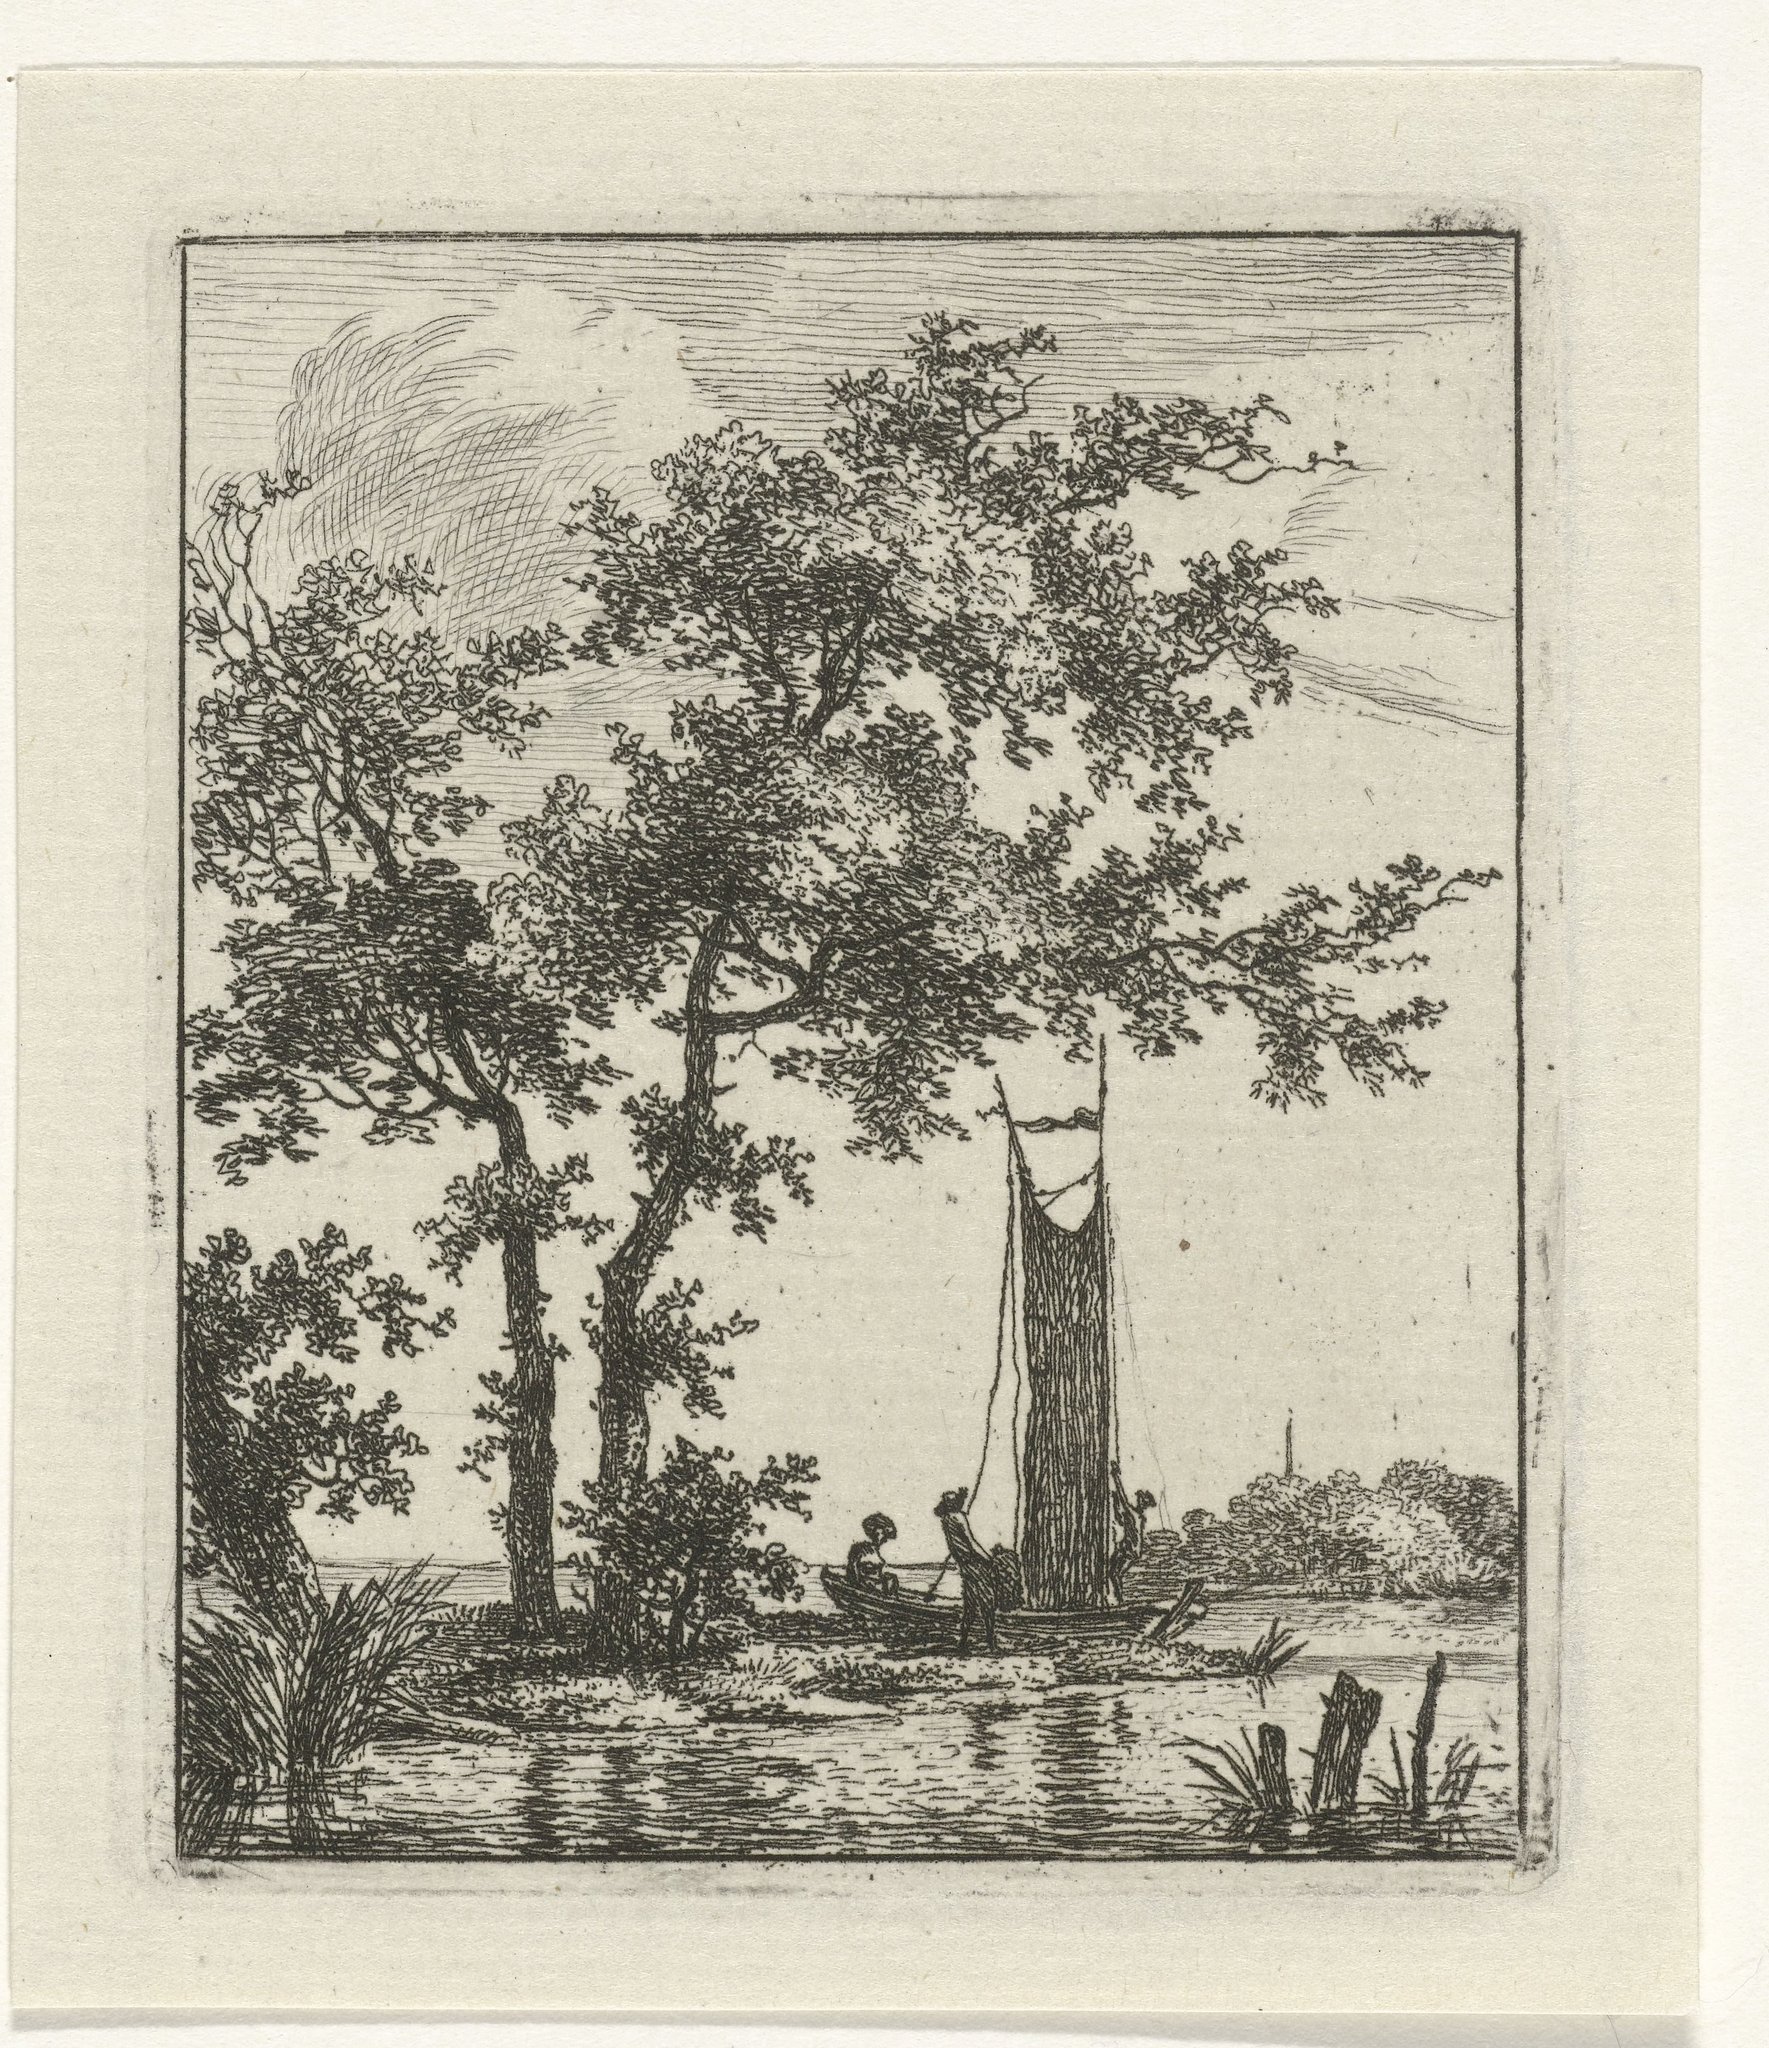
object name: print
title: Heisen van het zeil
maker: hermanus fock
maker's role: conservator, draughtsman, painter, print maker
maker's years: 1766-1822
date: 1781-1822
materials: paper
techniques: etching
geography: amsterdam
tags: sailing-ship, sailing-boat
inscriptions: collector's mark: Lugt 2228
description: Een rivierlandschap met een schuitje aan de waterkant, nabij twee bomen. In de boot twee personen, waarvan er één het zeil hijst. Een derde persoon staat op de oever.